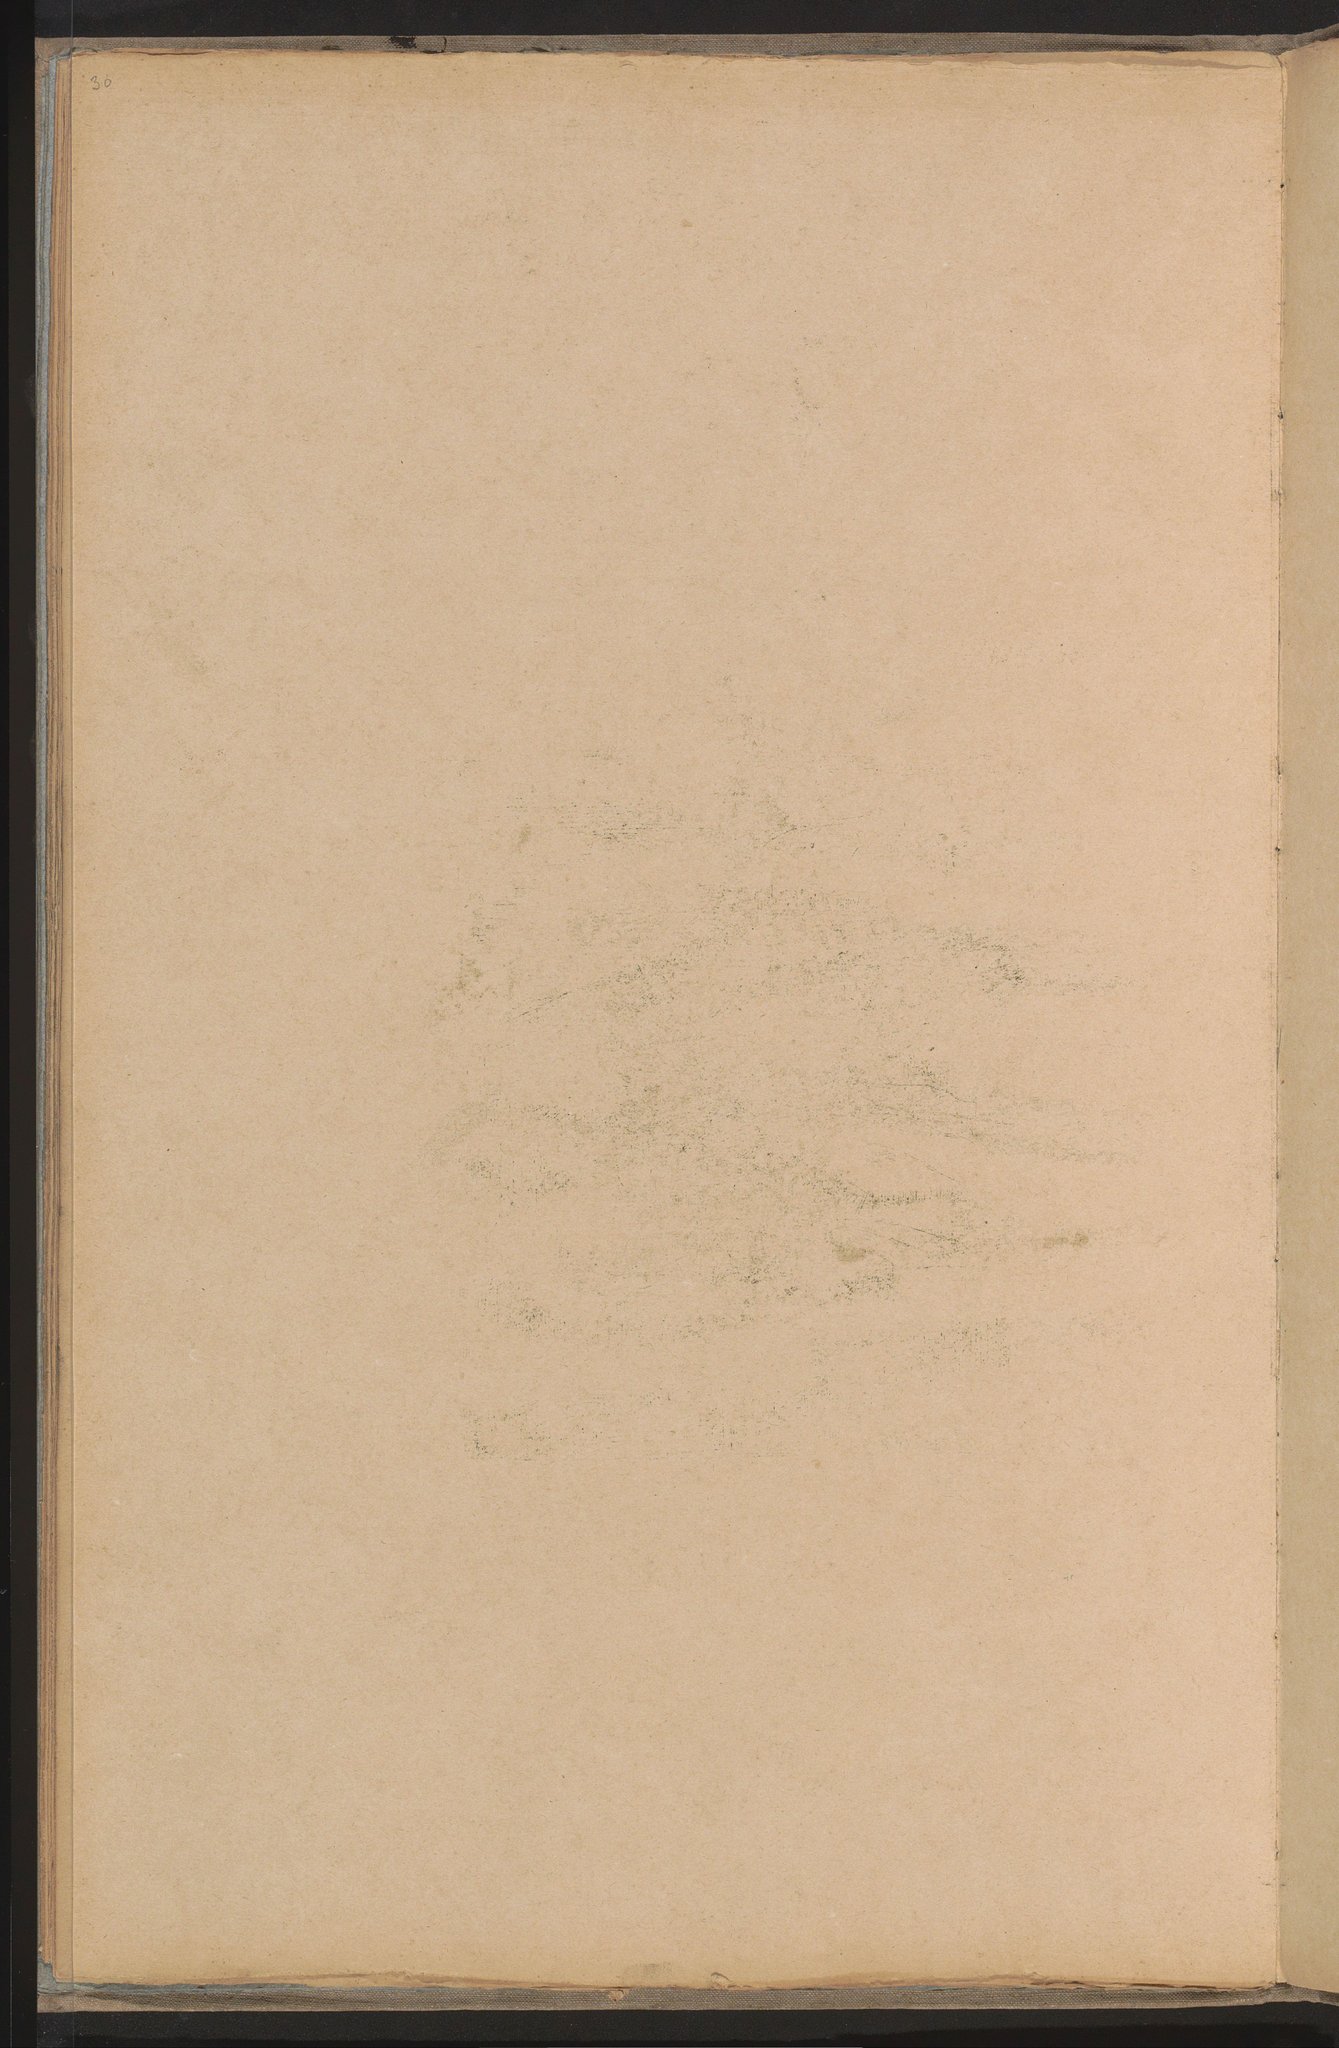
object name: sketchbook leaf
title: Abklatsch van een tekening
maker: willem witsen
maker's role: draughtsman, painter, print maker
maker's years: 1860-1923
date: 1884-1887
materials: paper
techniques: printmaking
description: Pagina 30 uit een schetsboek met 38 bladen.